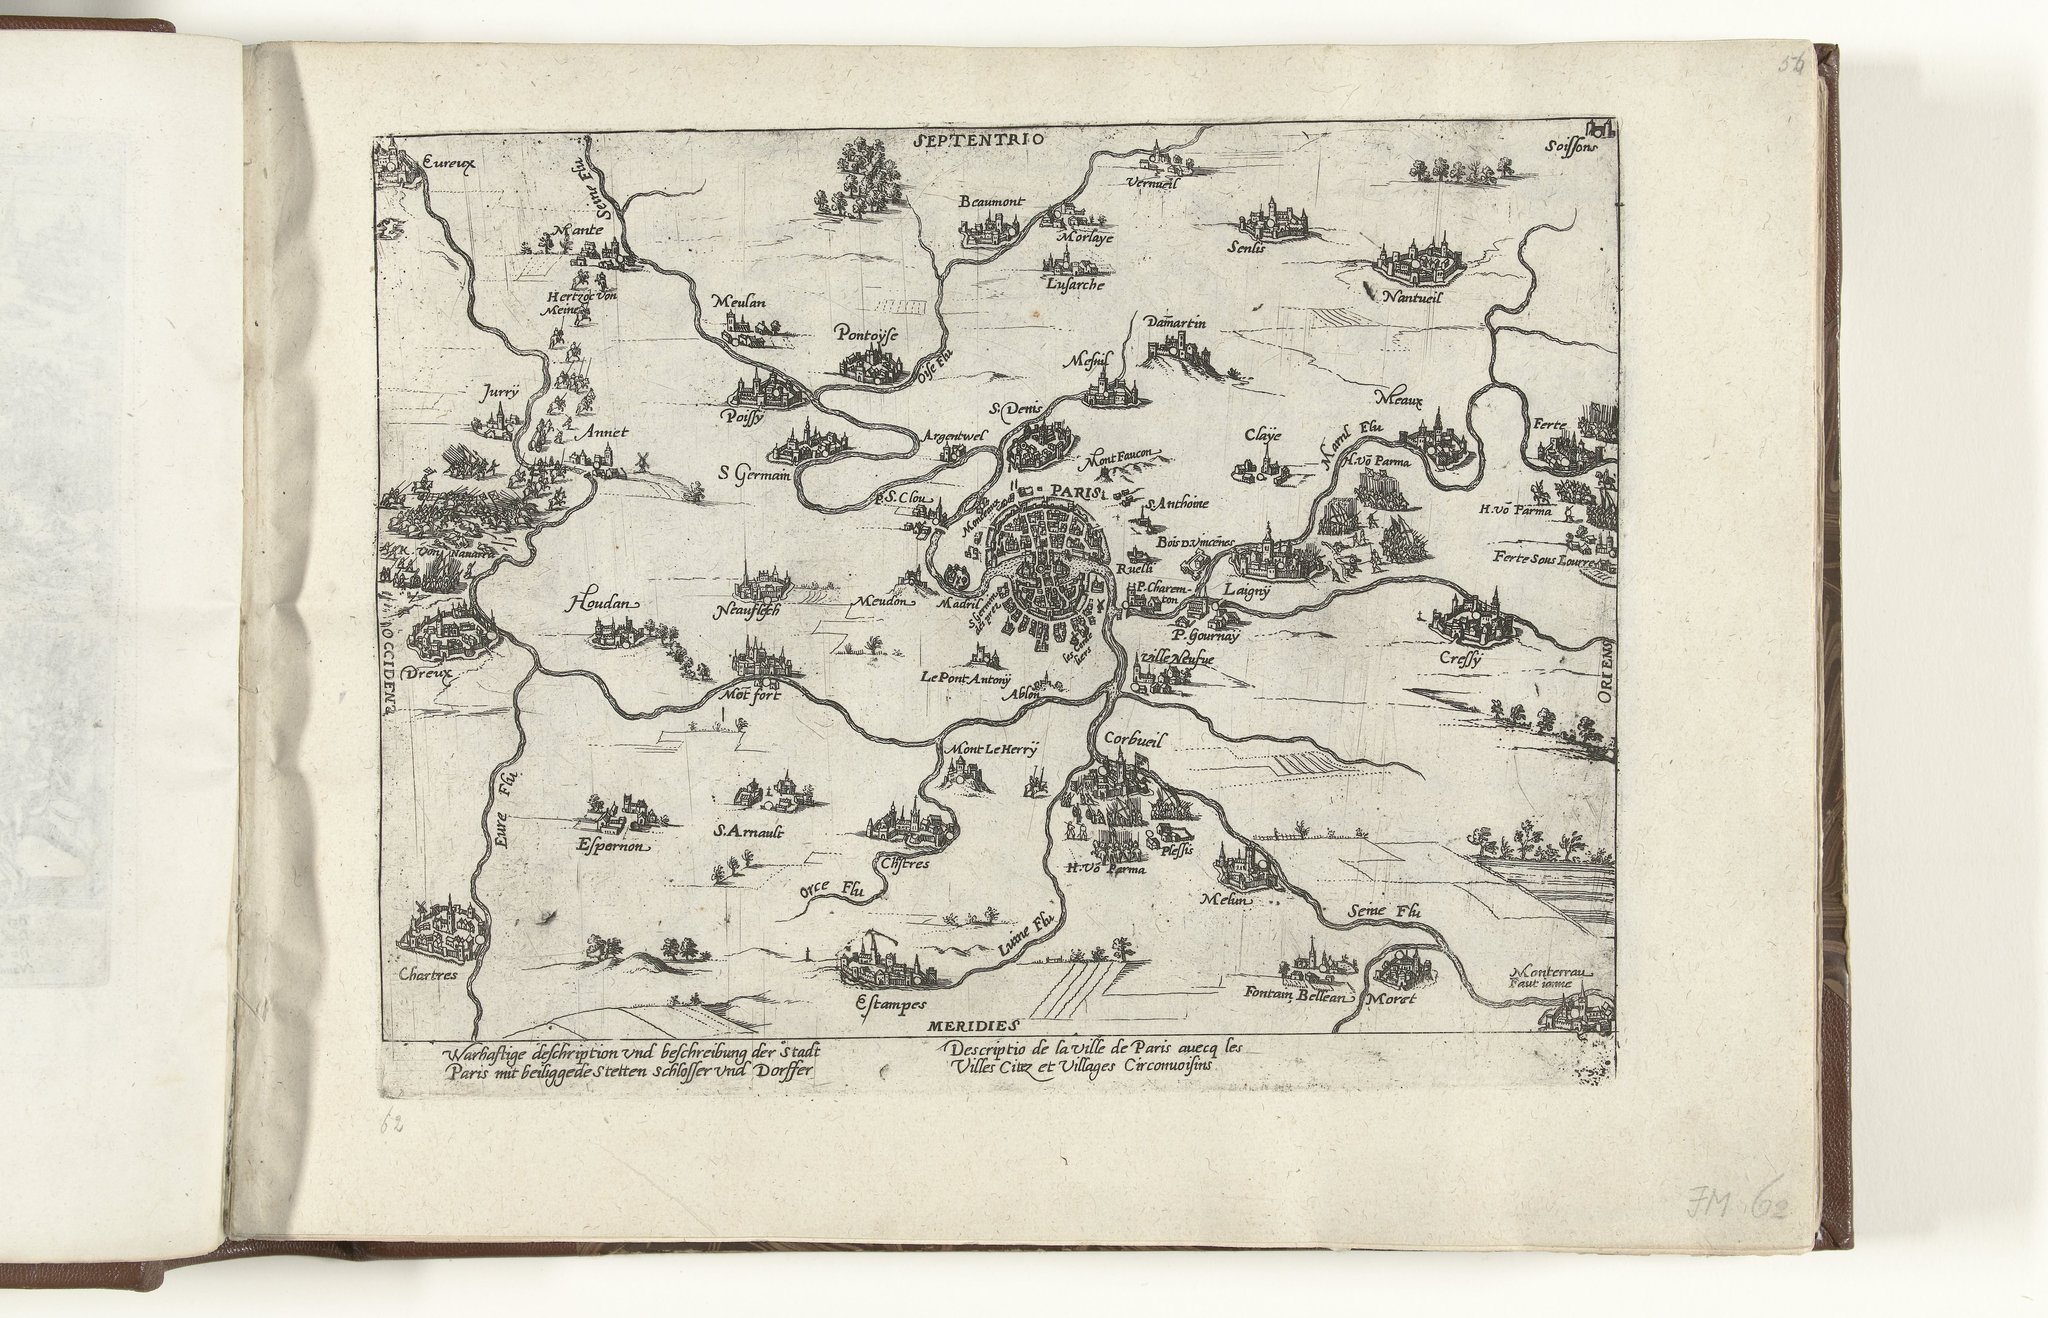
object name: print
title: Kaart van Parijs en omgeving, 1590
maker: frans hogenberg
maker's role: print maker, publisher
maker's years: 1538-1590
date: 1590-1612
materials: paper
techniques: etching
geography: cologne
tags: rome, alessandro farnese (landvoogd van de nederlanden en hertog van parma en piacenza), paris, hendrik iv (koning van frankrijk en navarra), maps of separate countries or regions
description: Kaart van Parijs en omgeving met de ligging van de troepen van Hendrik IV en de hertog van Parma, 1590. Met onderschrift van 2 regels in het Duits en 2 regels in het Frans. Ongenummerd.